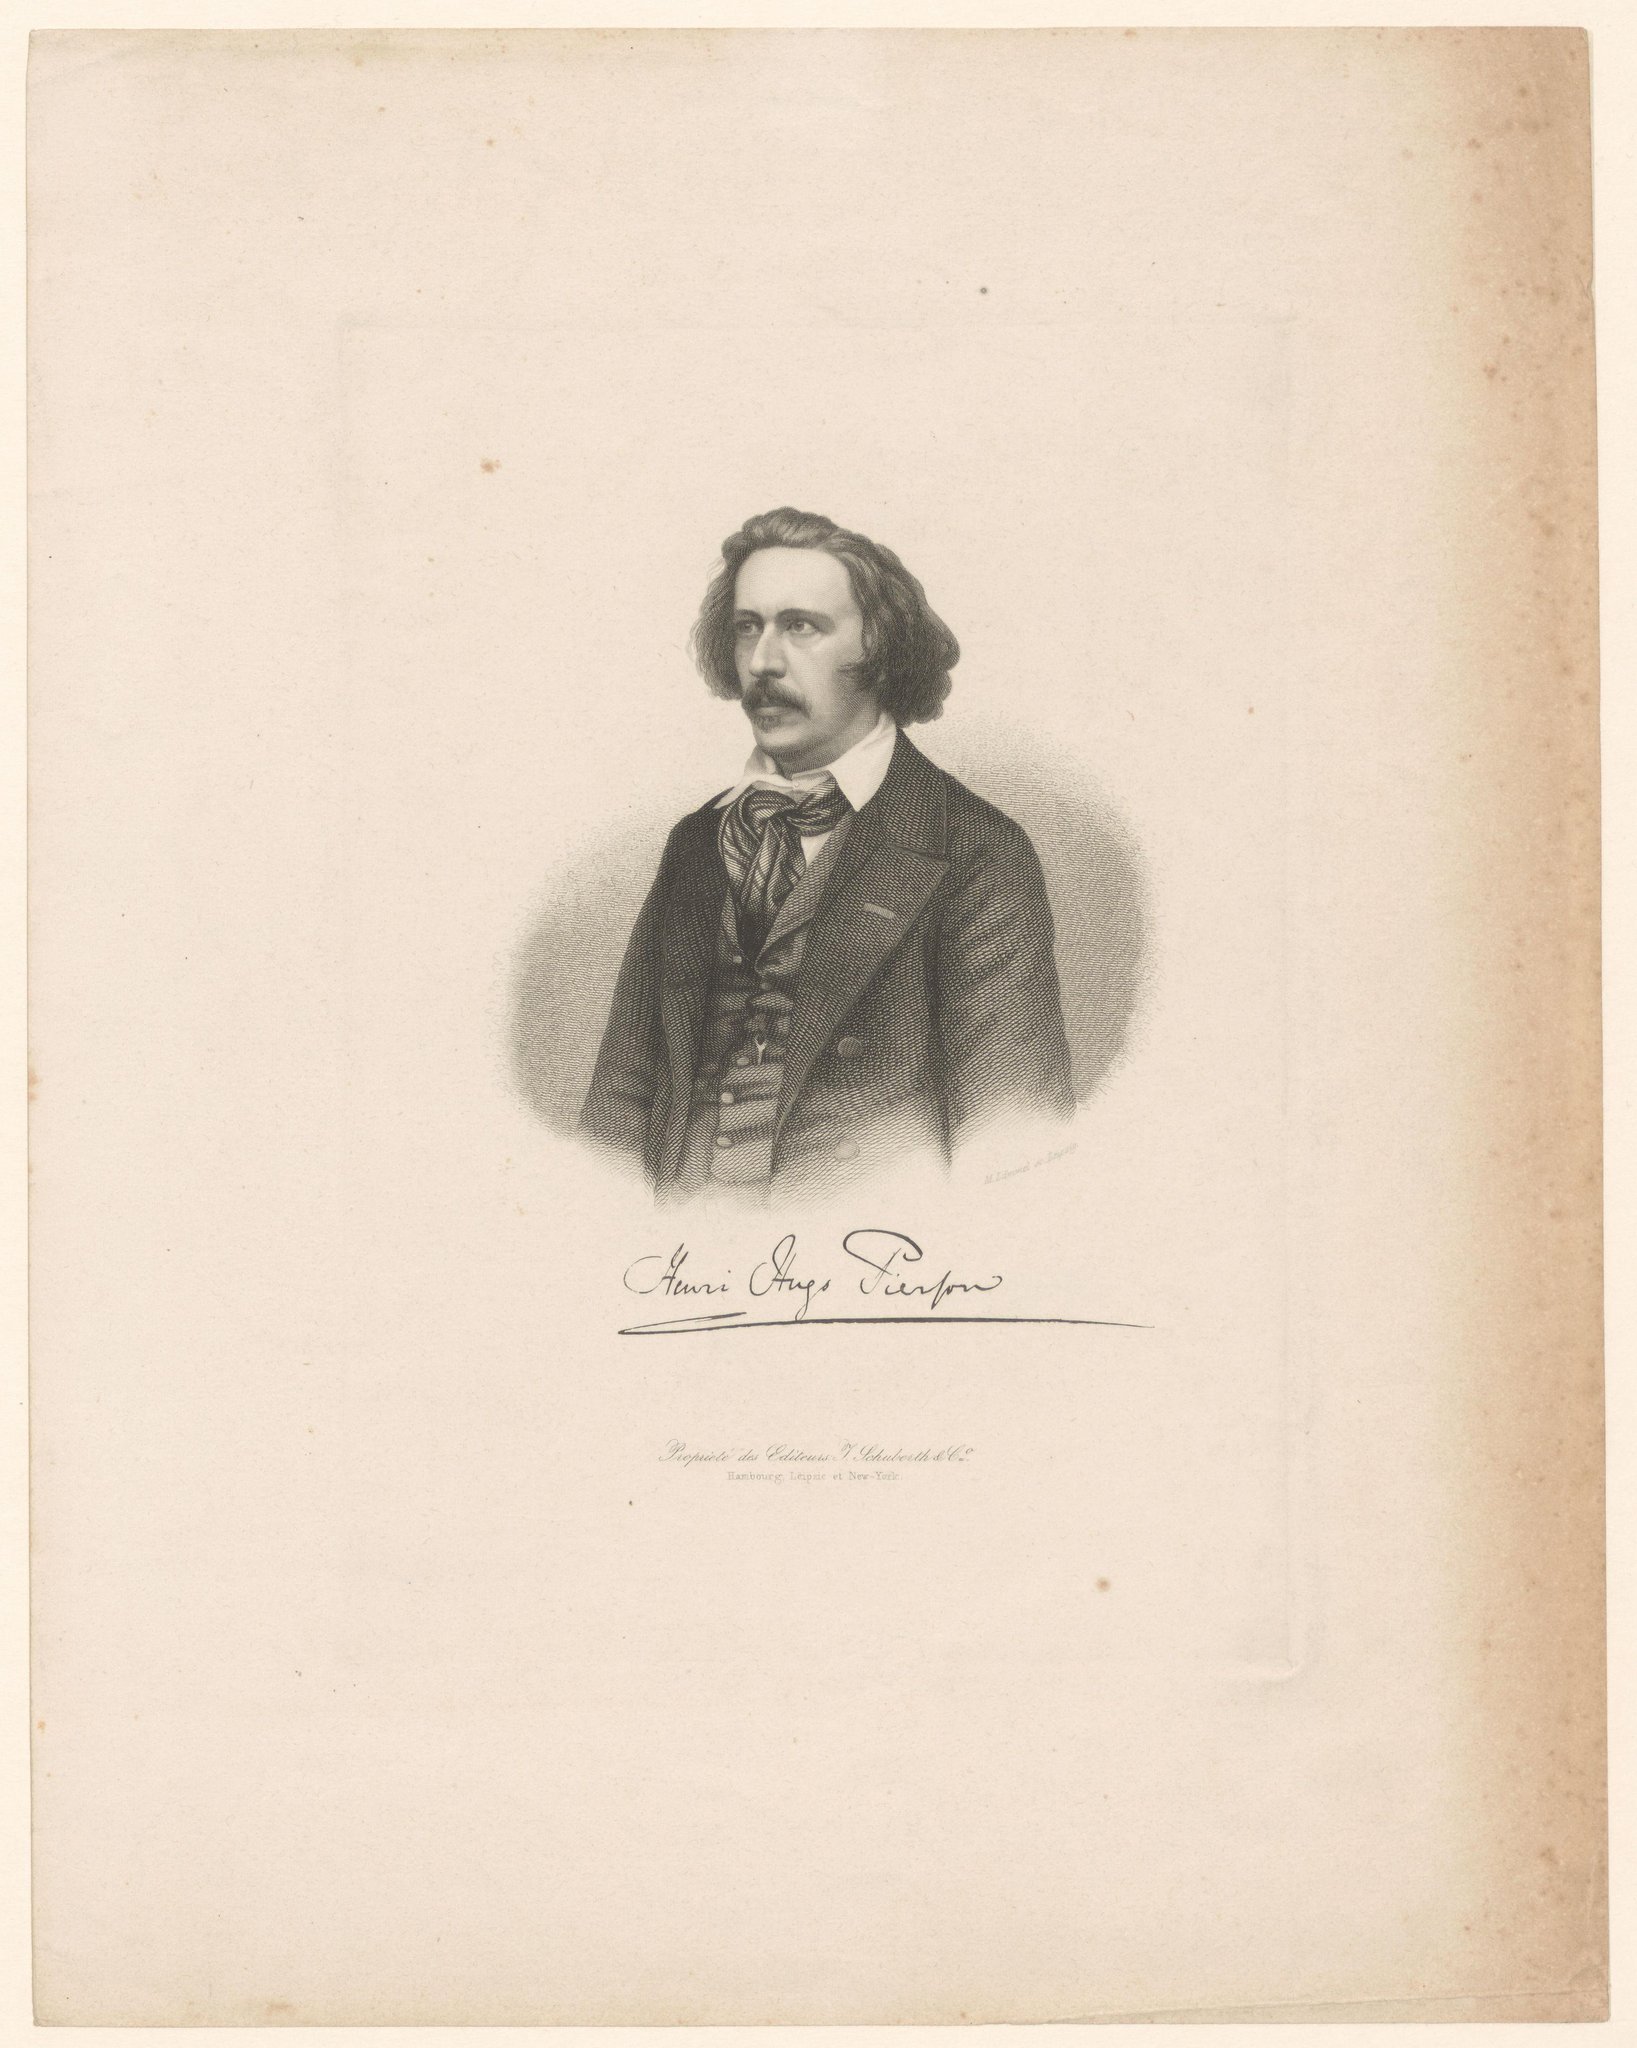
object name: print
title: Portret van Henry Hugo Pierson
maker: moritz lämmel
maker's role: print maker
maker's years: 1822-1866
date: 1850-1866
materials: paper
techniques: engraving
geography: leipzig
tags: historical persons, portrait of composer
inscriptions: collector's mark: Lugt 2228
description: Een facsimile signatuur in de ondermarge.